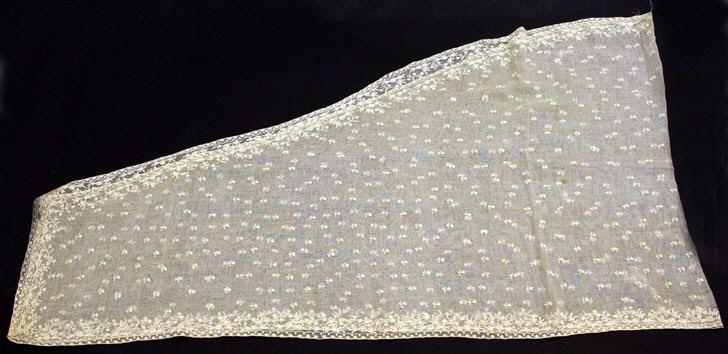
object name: headcloth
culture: french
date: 1810-1814